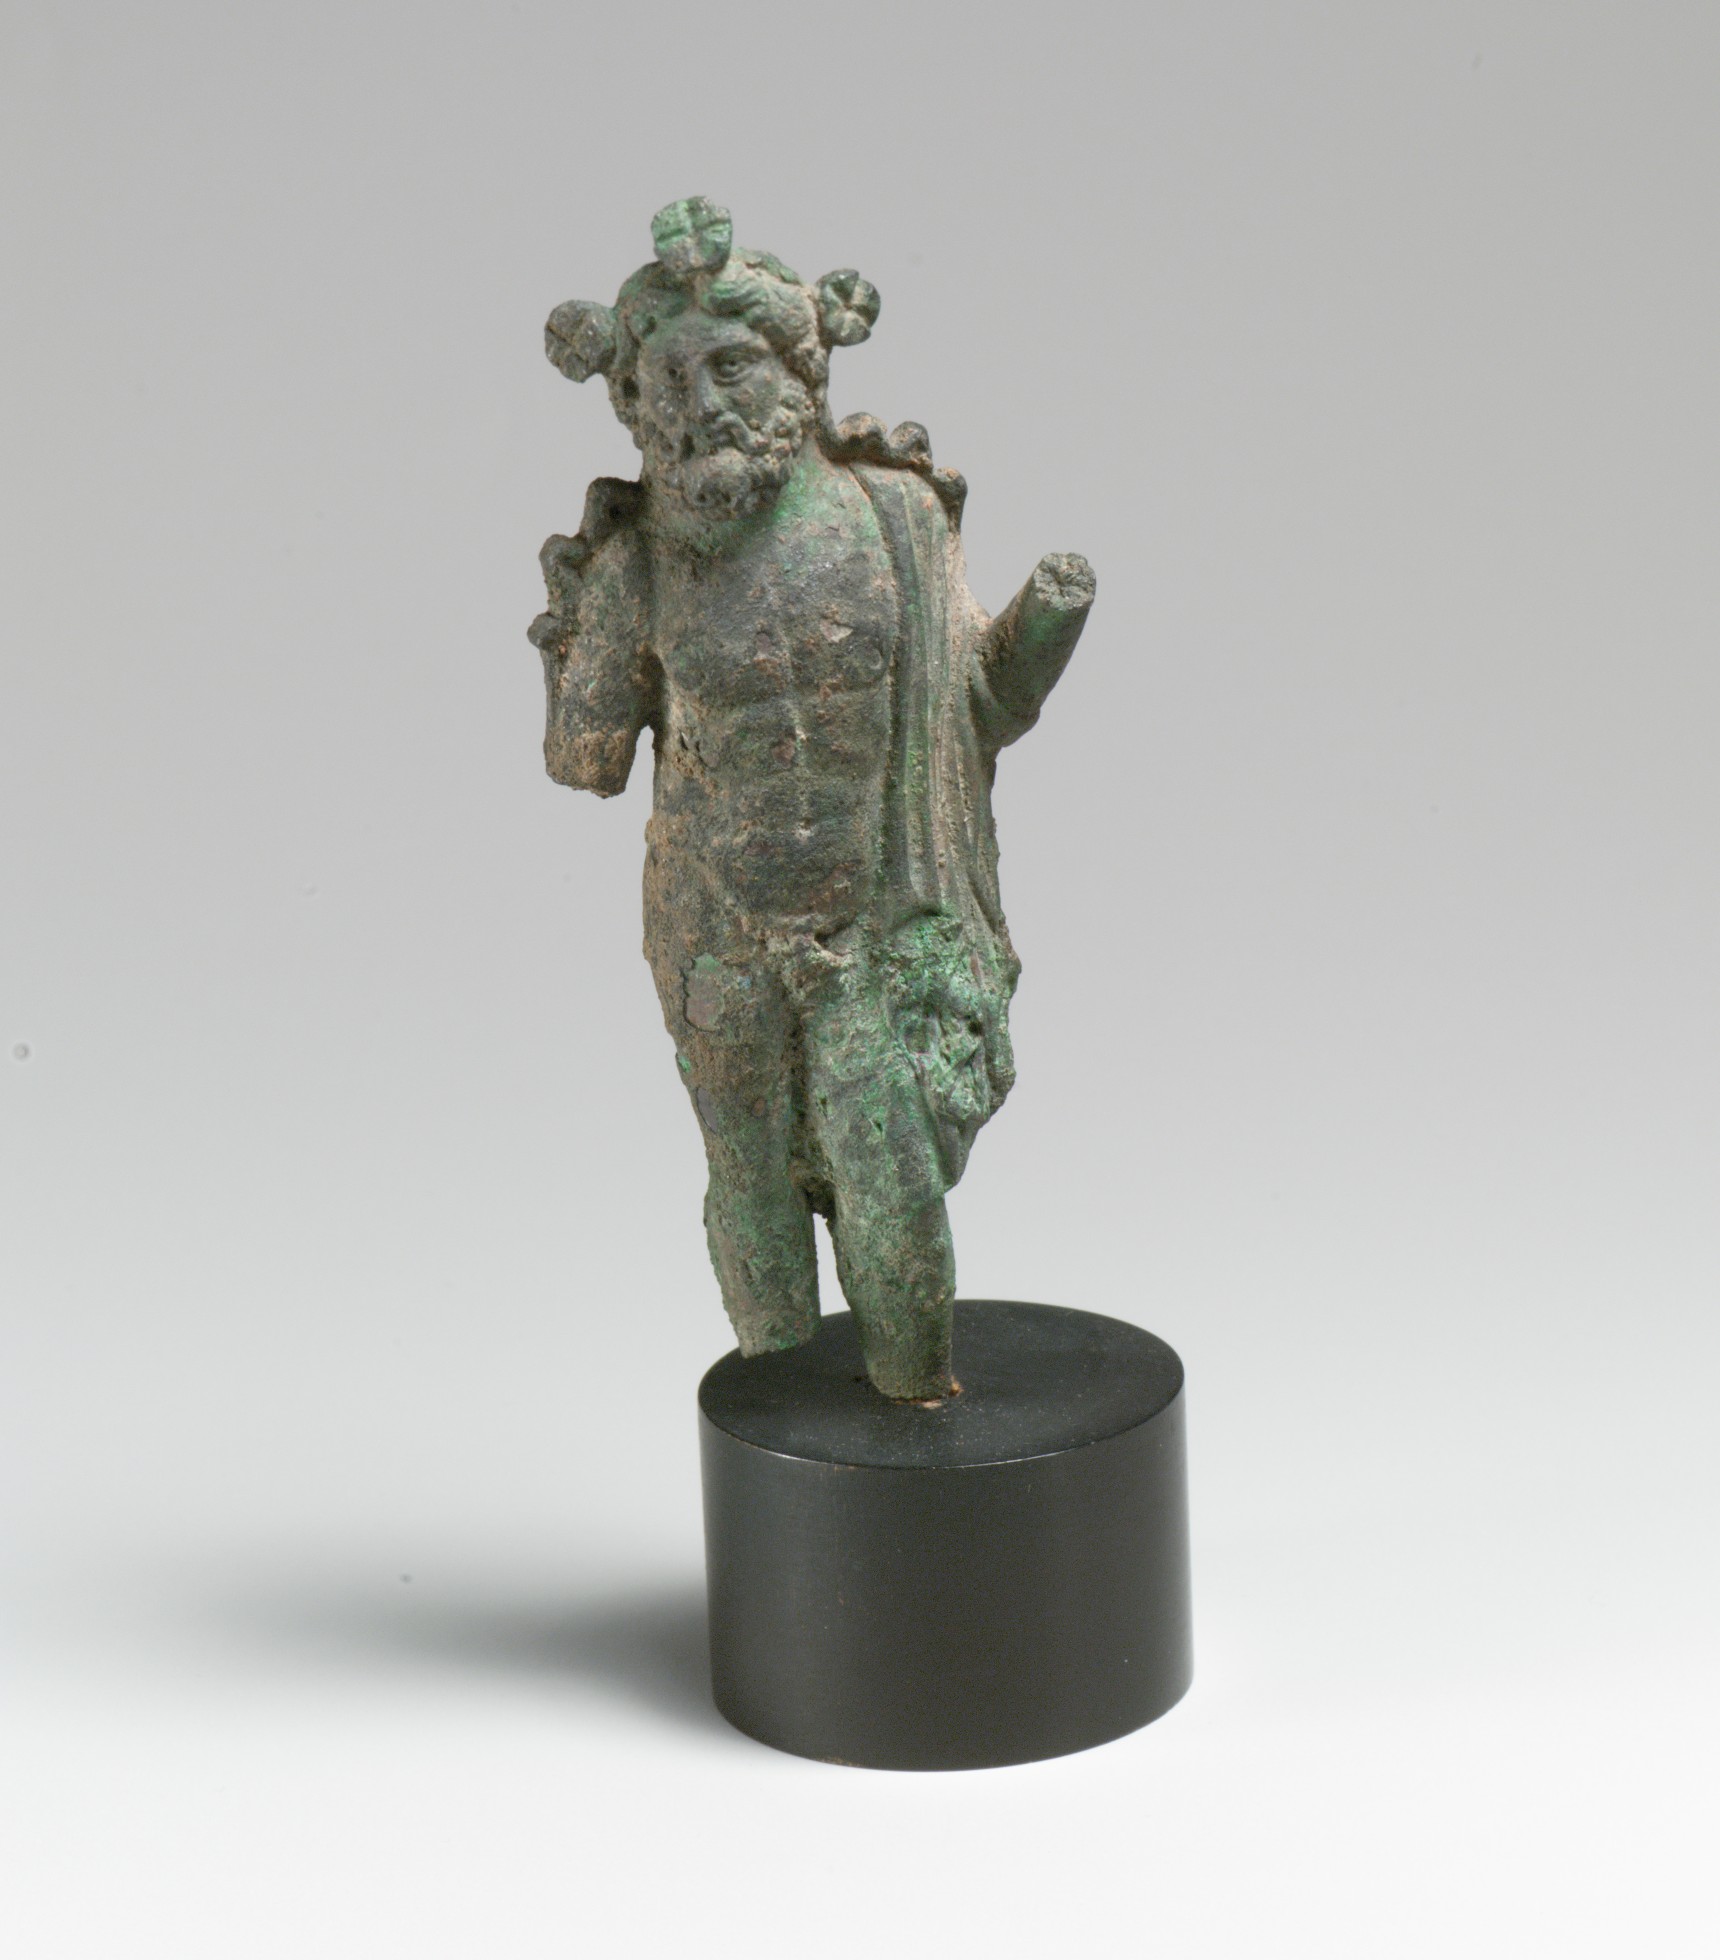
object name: statuette of zeus or jupiter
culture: roman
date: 1-300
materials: bronze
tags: zeus,jupiter